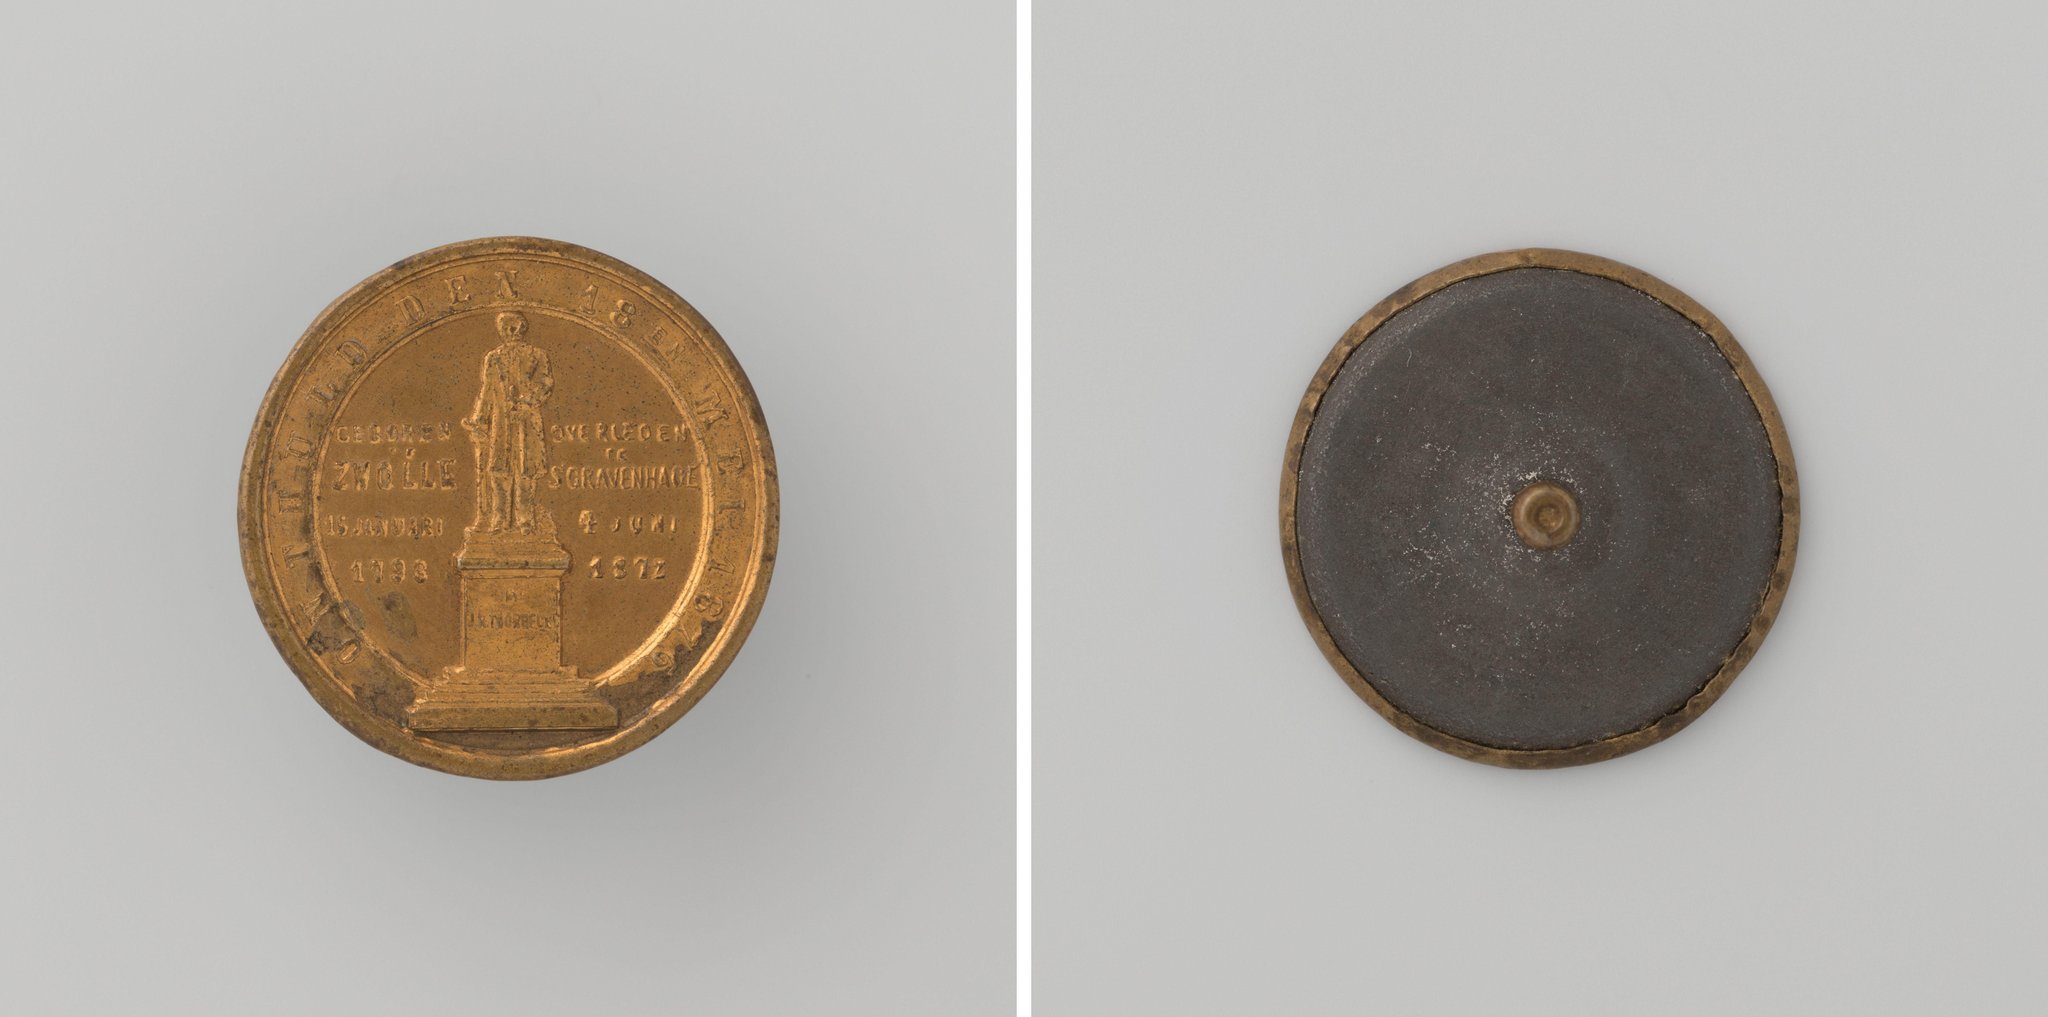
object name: button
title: Oprichting van een standbeeld voor Johan Rudolf Thorbecke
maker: Anonymous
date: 1872-1900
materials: copper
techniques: striking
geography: netherlands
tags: the hague, johan rudolf thorbecke, netherlands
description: Eenzijdig met uitsteeksel aan keerzijde. Voorzijde: standbeeld tussen opschriften binnen omschrift. Keerzijde: blanco.